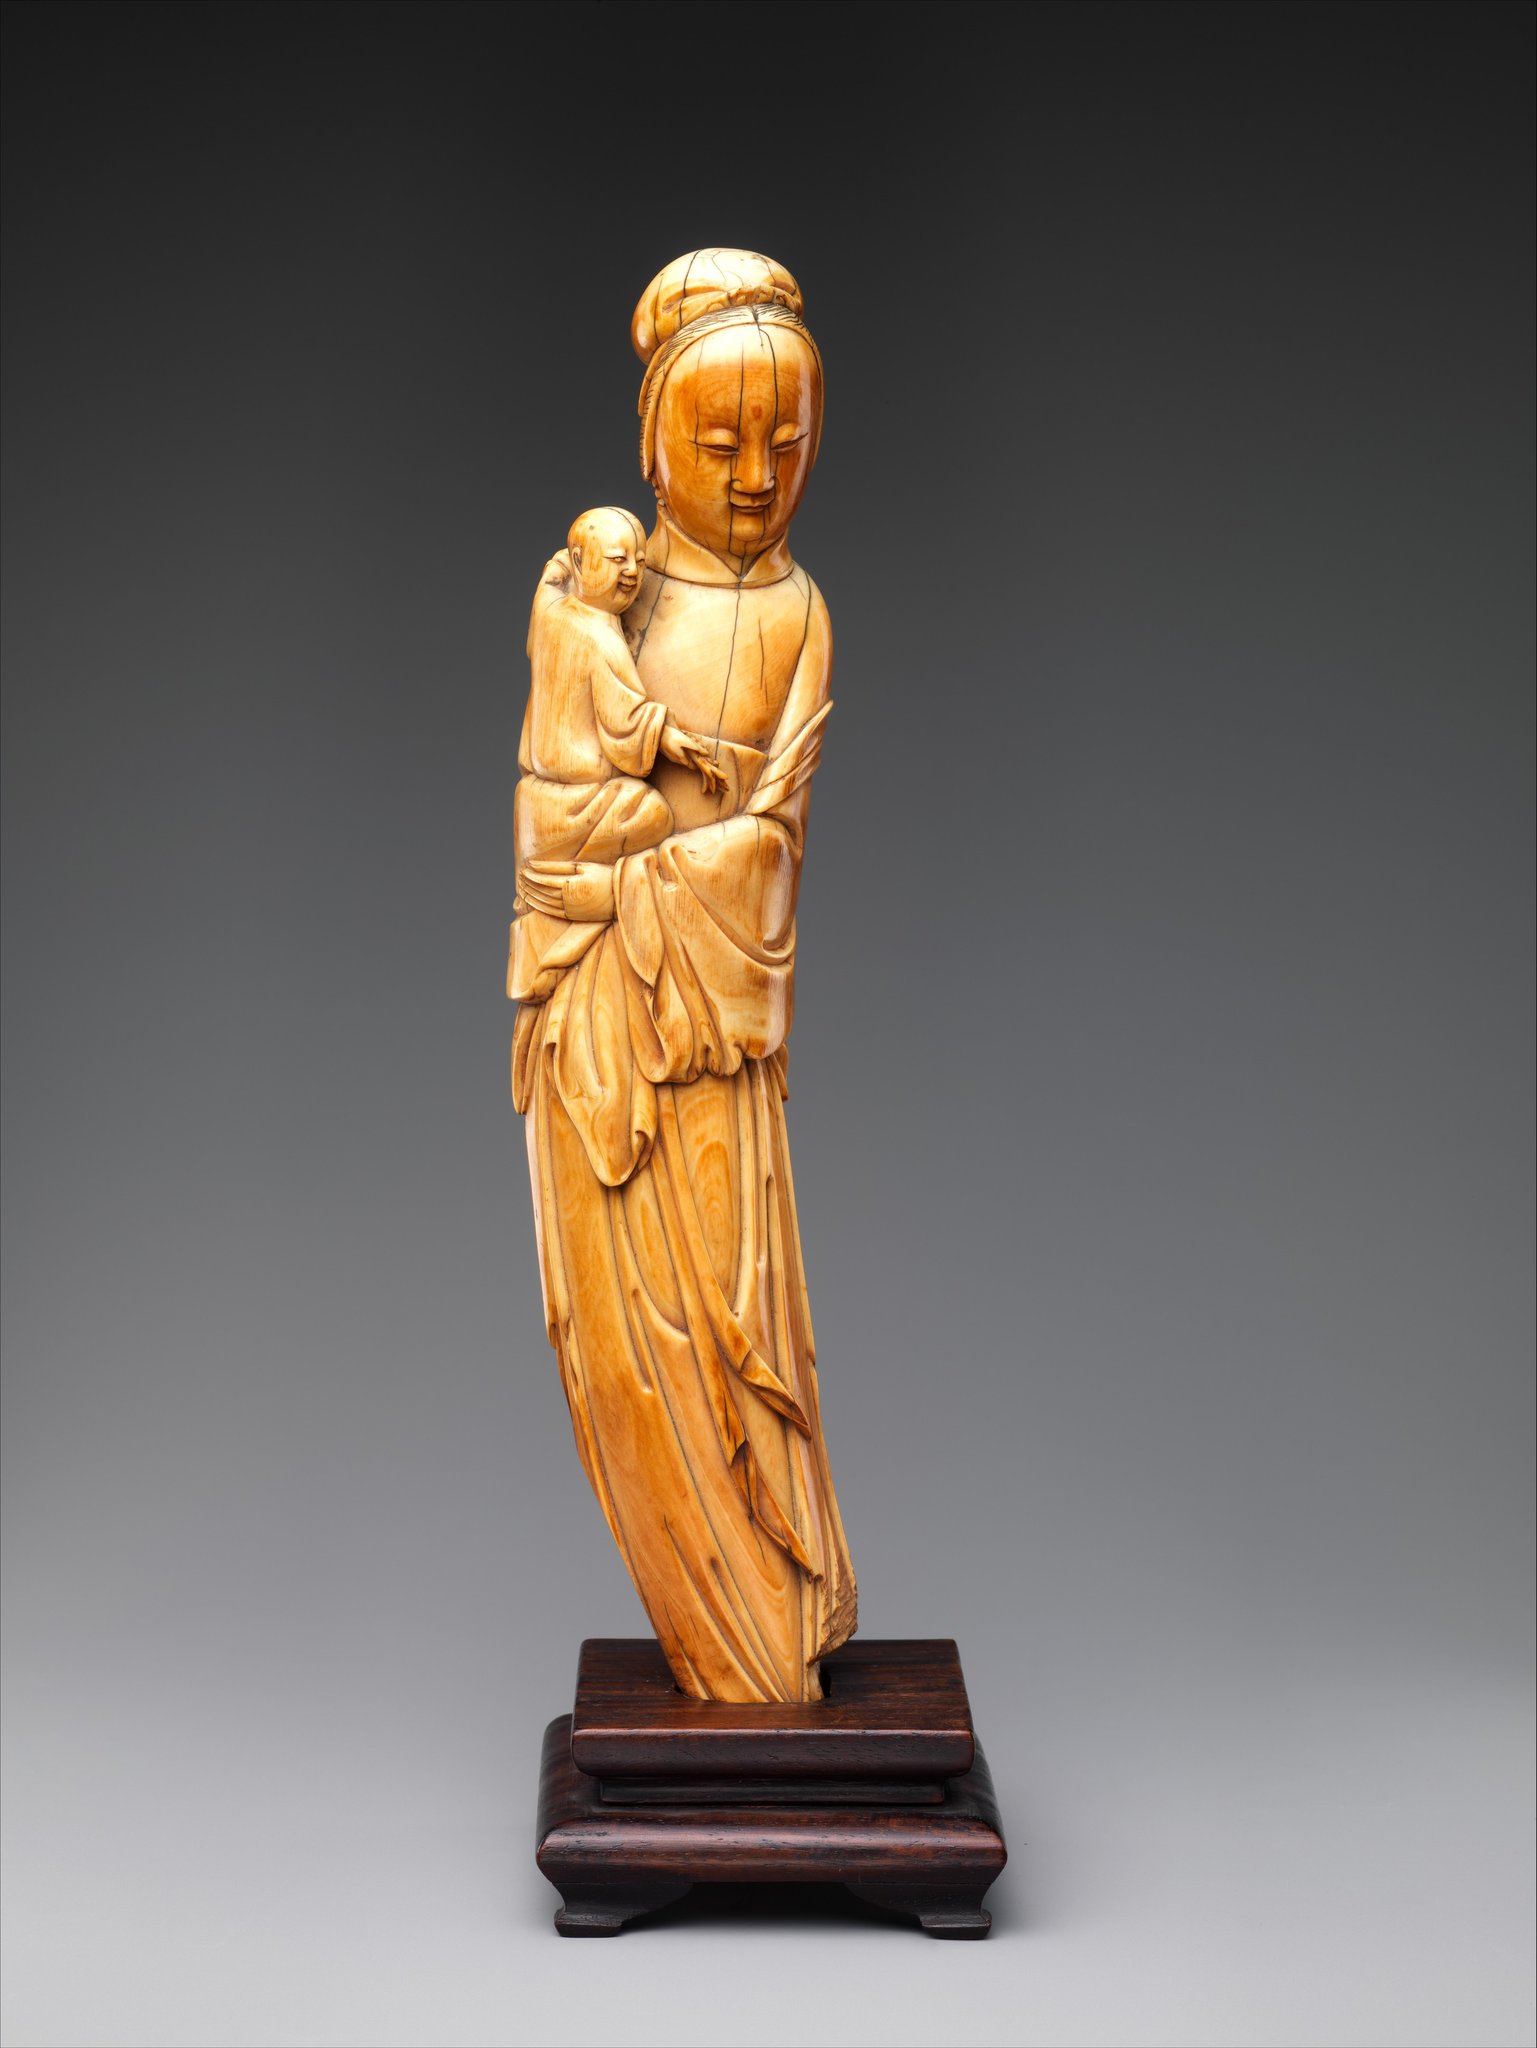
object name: figure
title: Bodhisattva Guanyin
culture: chinese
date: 1501-1600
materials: ivory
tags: children,buddhism,avalokiteshvara,bodhisattvas